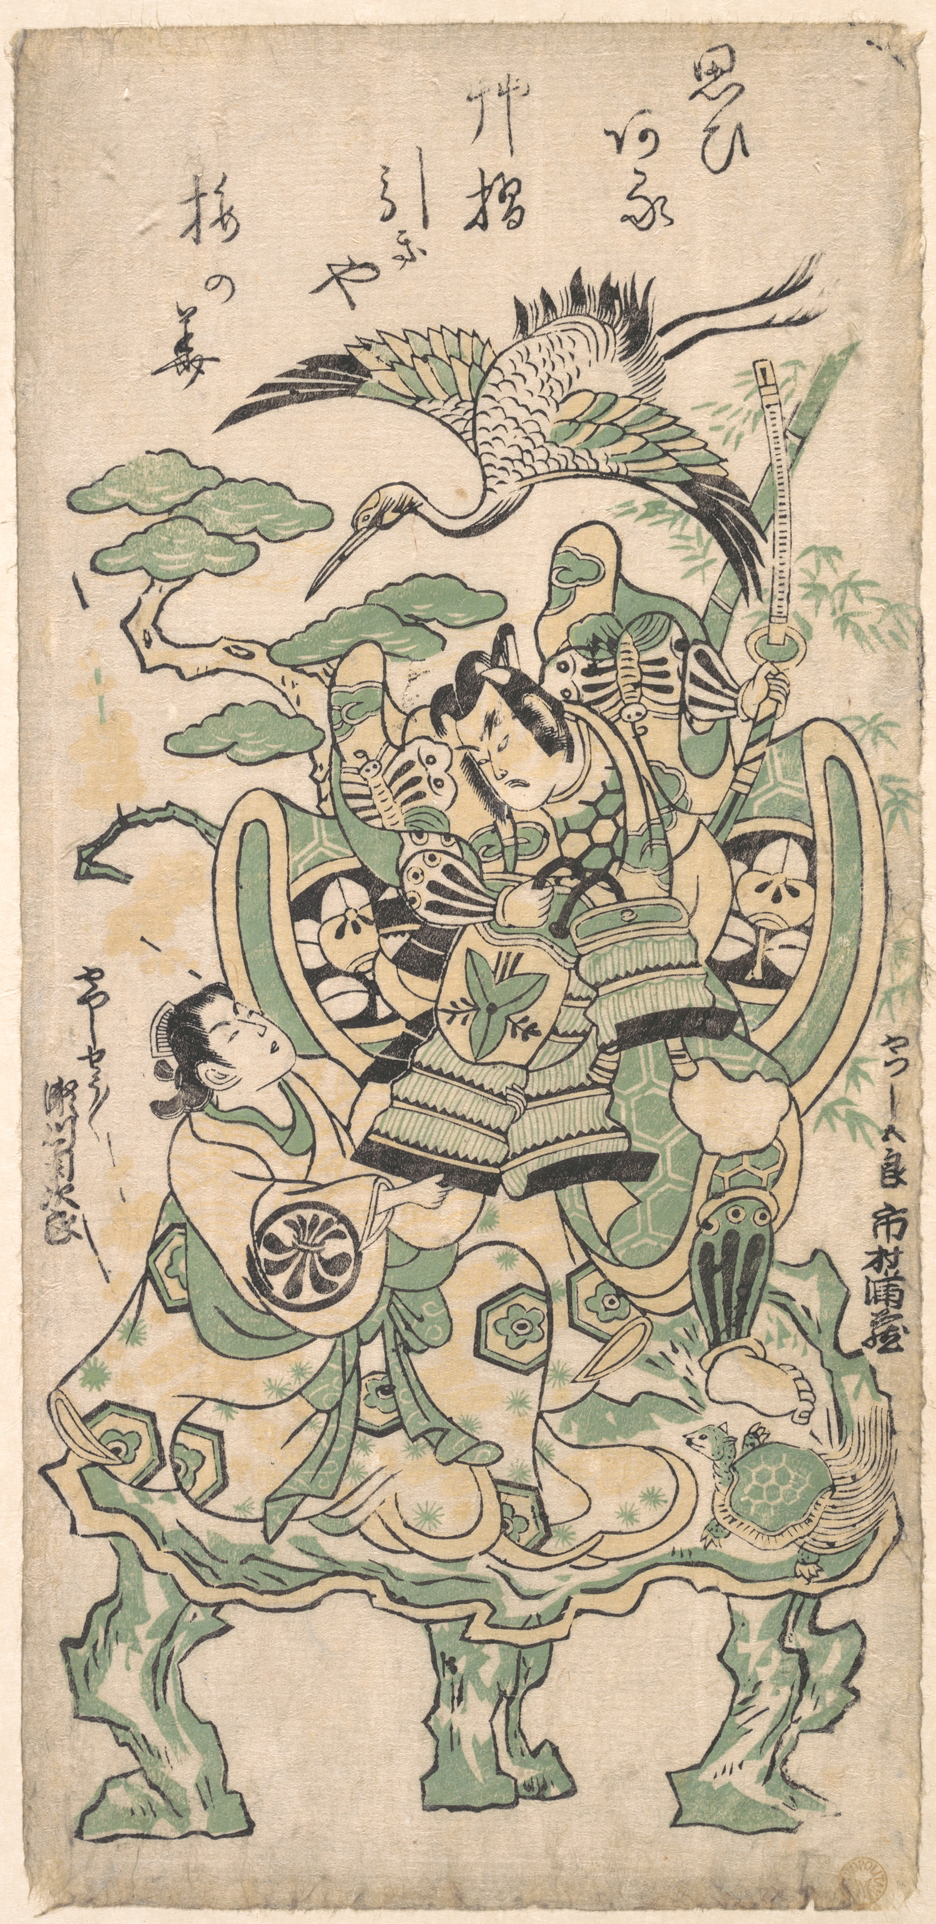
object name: print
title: Ichimura Manzo as Yatsushi Goro and Segawa Kikujiro as Yatsushi Shosho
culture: japanese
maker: torii kiyomasu i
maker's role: artist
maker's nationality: japanese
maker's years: 1696-1716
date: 1745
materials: ink, paper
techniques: woodblock print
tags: birds,men,women,actors